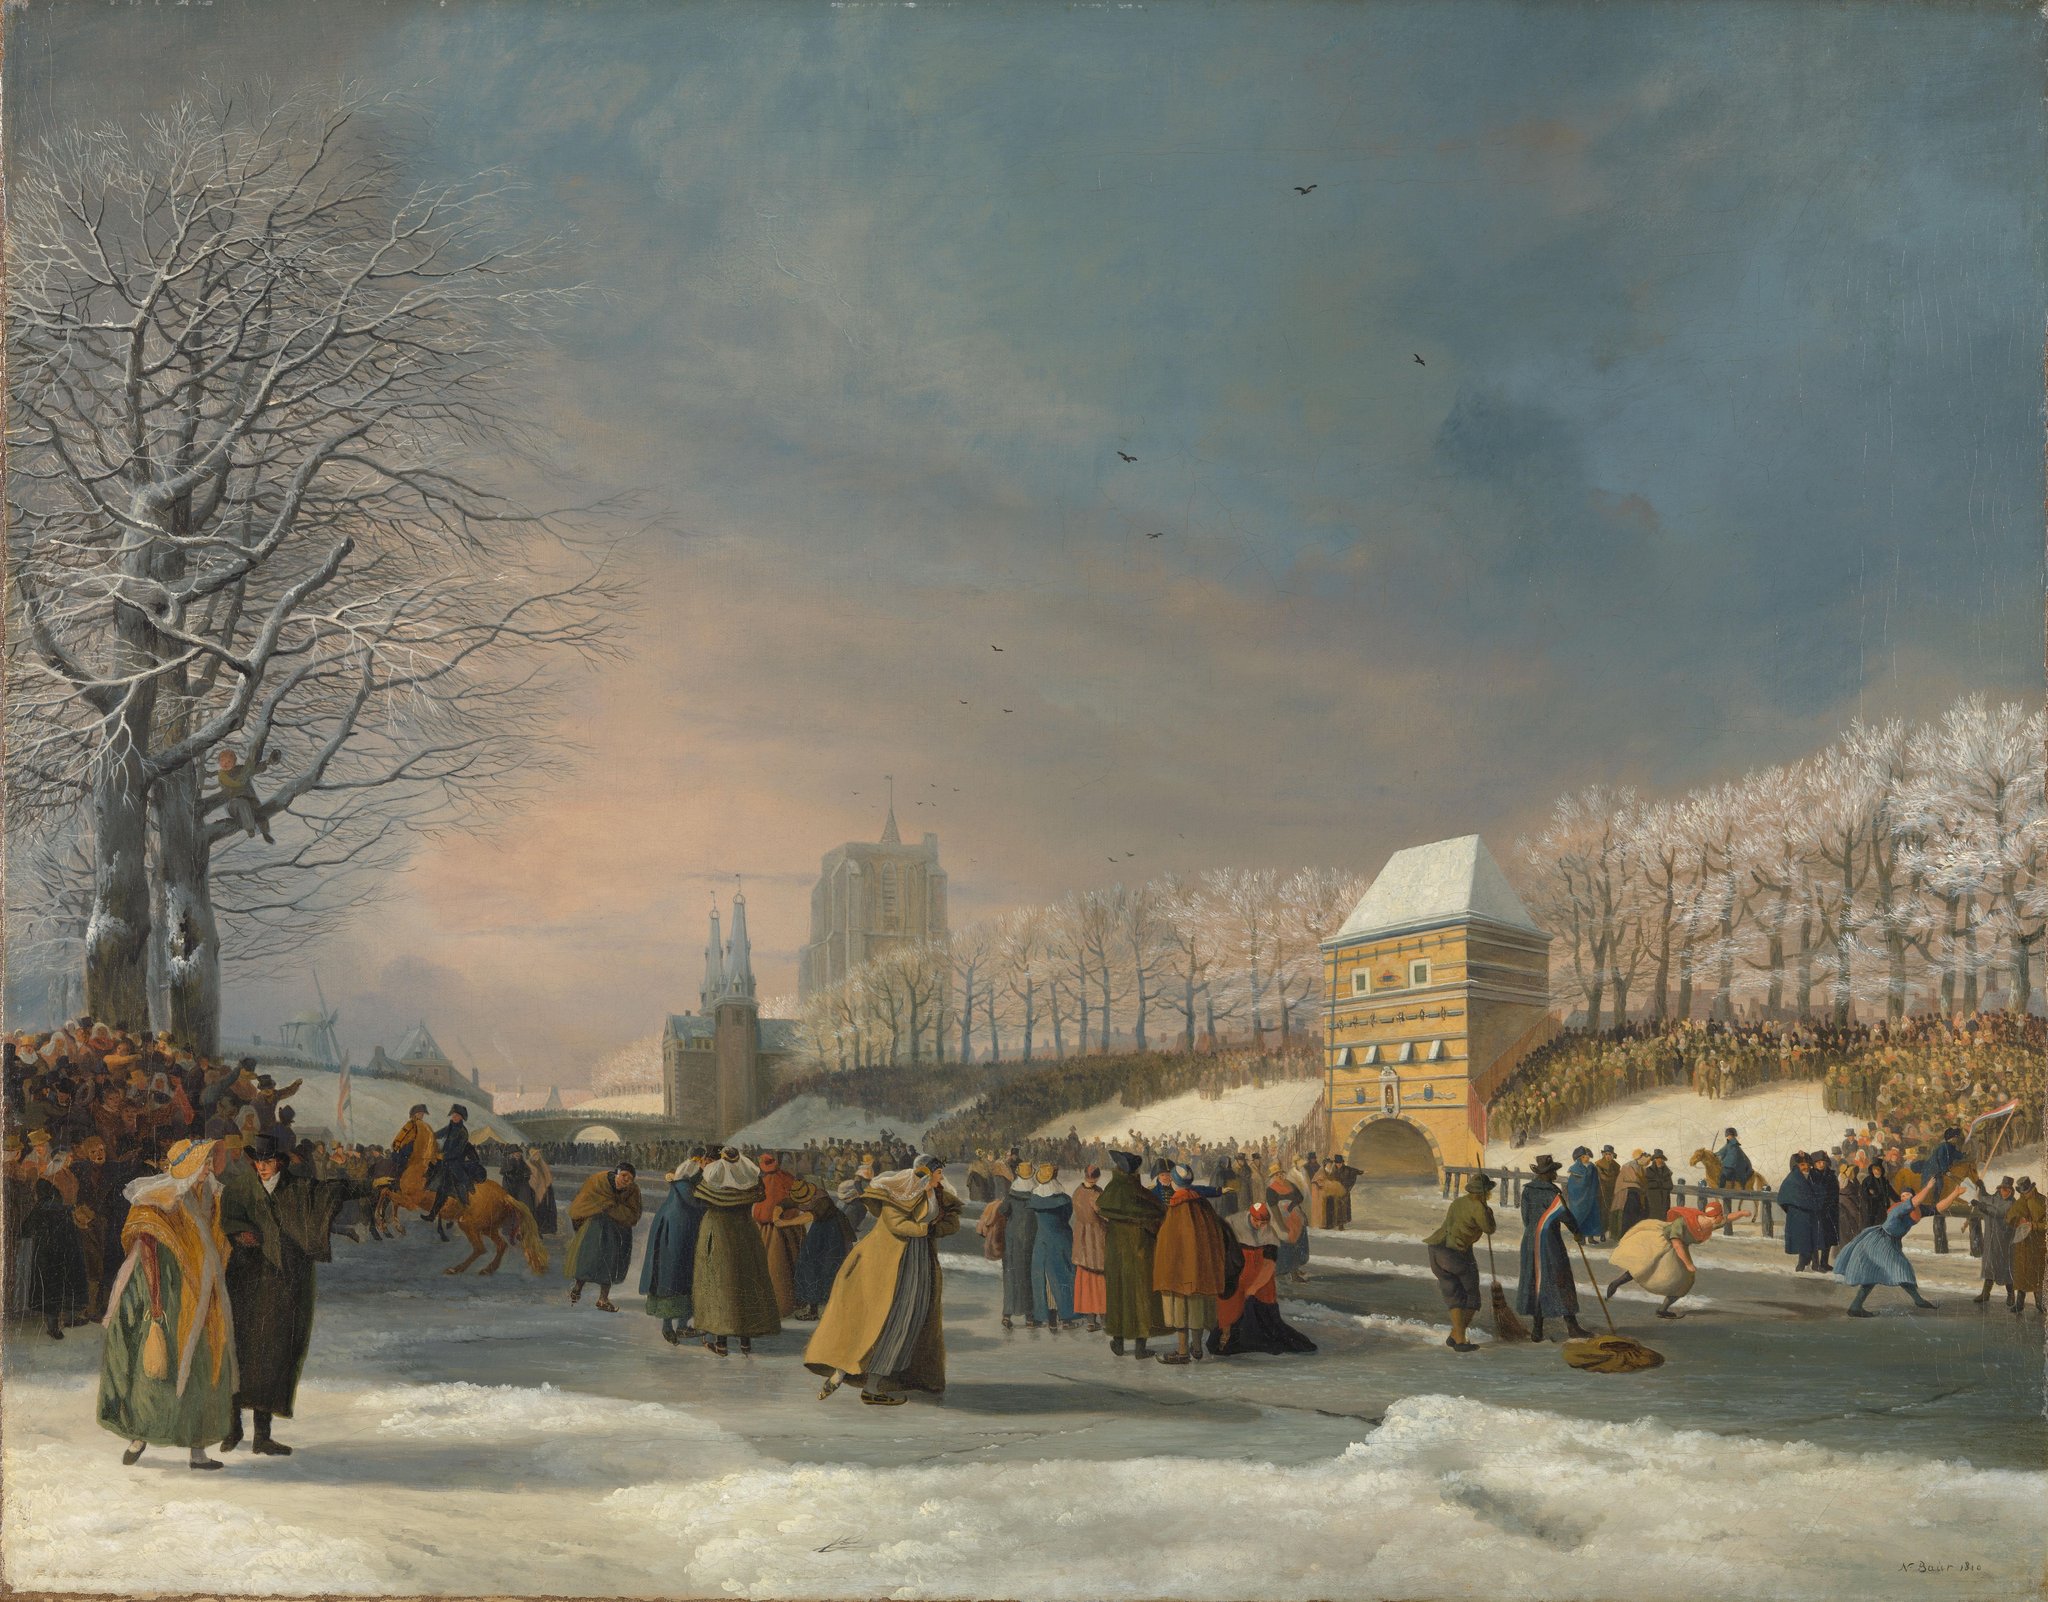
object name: painting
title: Skating Competition on the Stadsgracht in Leeuwarden on 21 January 1809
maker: nicolaas baur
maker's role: draughtsman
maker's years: 1767-1820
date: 1810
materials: canvas, oil, paint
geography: harlingen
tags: skates (winter sports) (+ the contest (sports, games, etc.))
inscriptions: signature and date: ‘N. Baur 1810’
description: Thousands of people have flocked to see the final of a women’s skating competition. Houkje Gerrits Bouma crosses the finish line first. Elated, she throws up her arms in triumph. A boy has even climbed a tree to follow the event. During the winter season, everyone went out on the ice, and women commonly participated in speed skating as well.